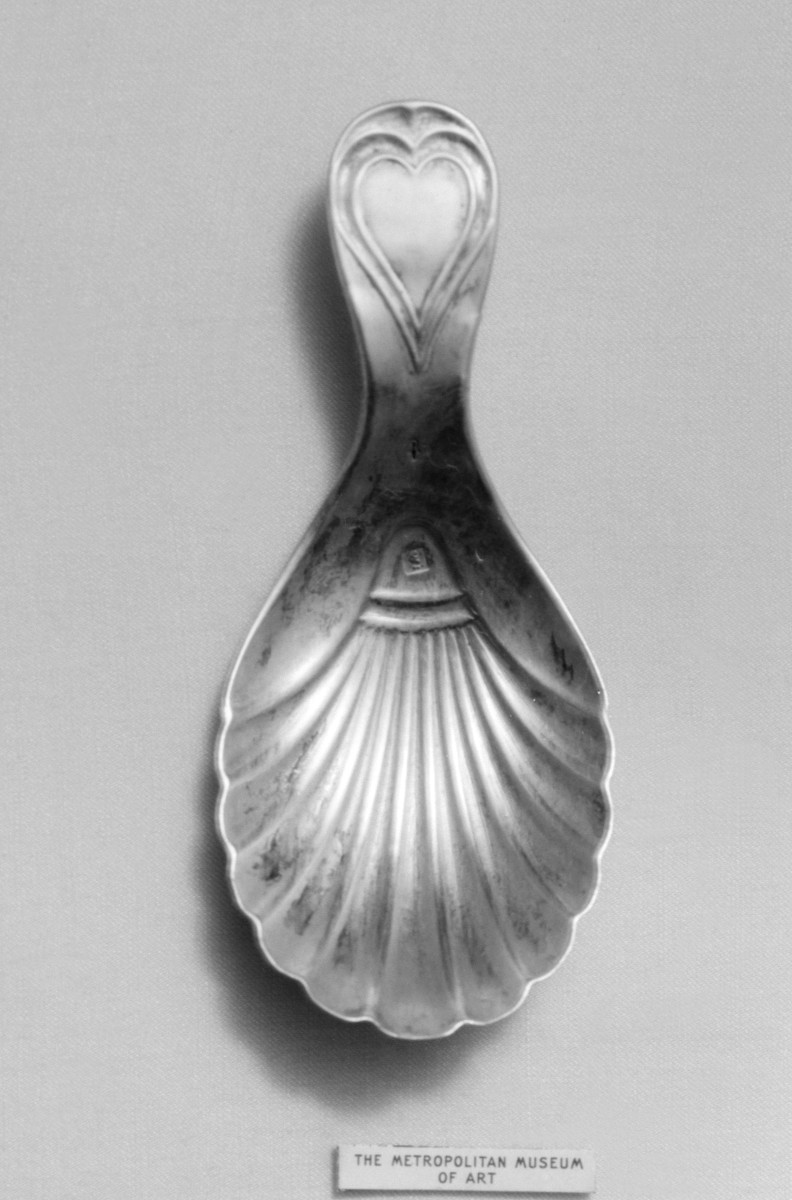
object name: caddy spoon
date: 1851-1900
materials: silver